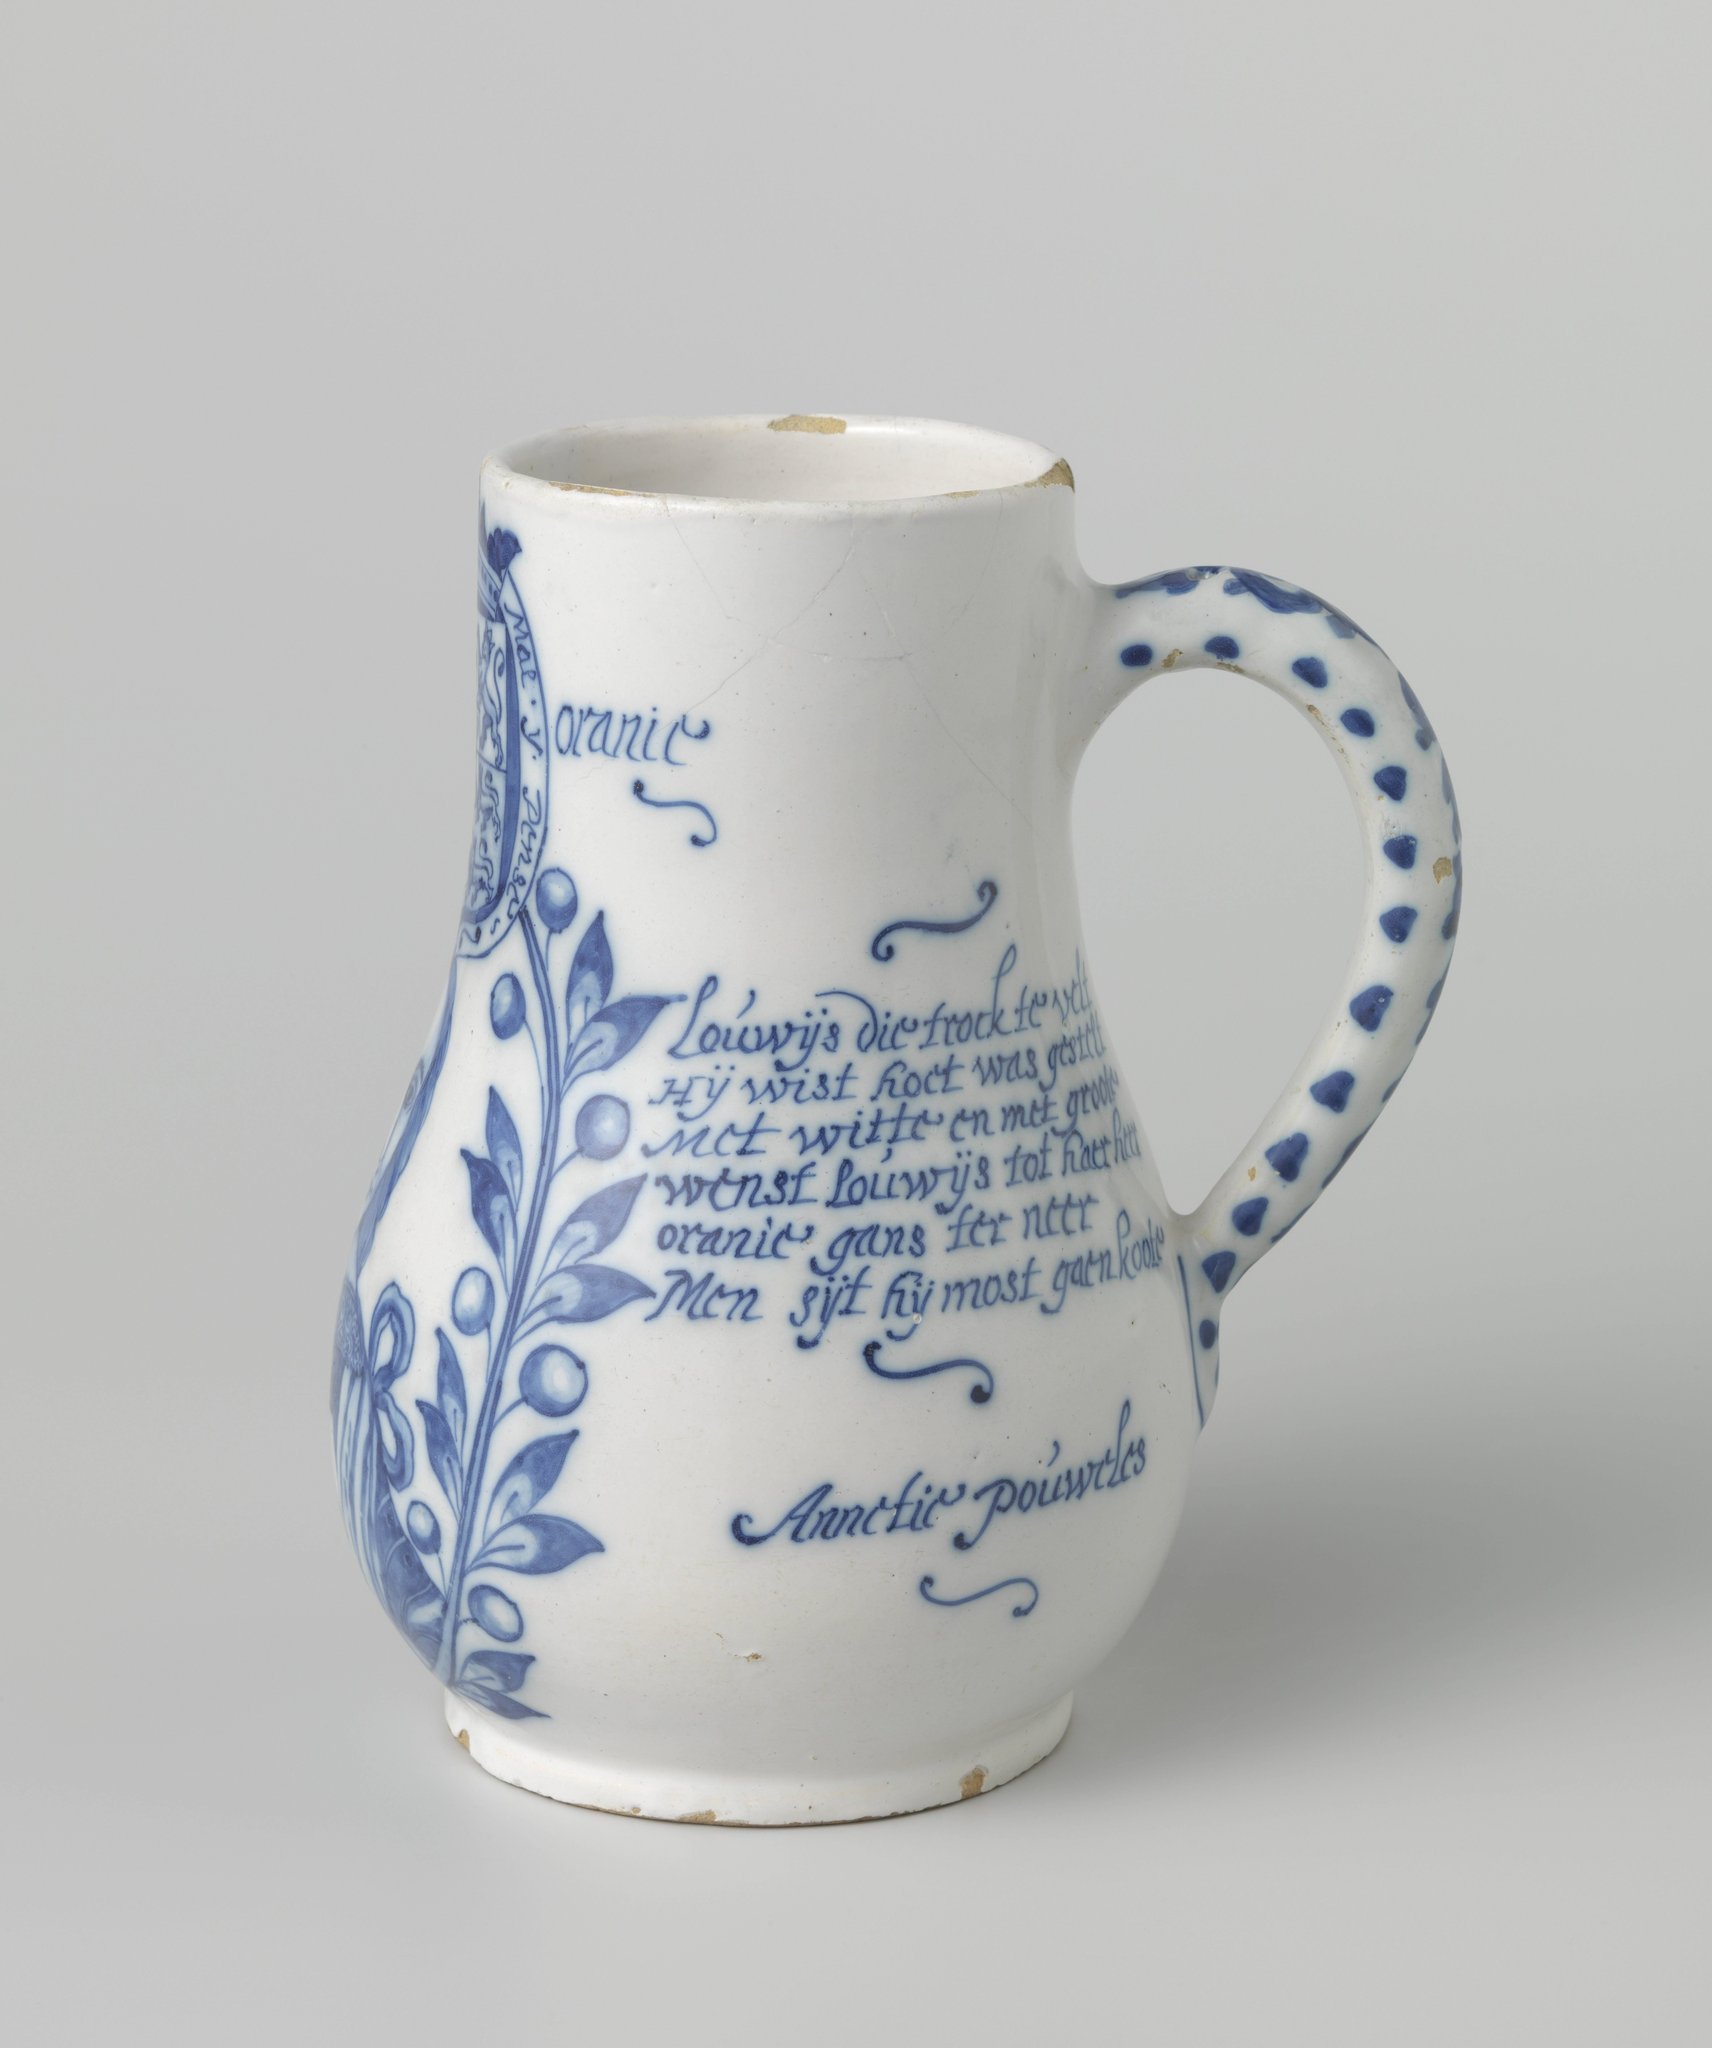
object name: ewer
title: Kan, beschilderd met het portret van Willem III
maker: Anonymous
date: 1674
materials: earthenware, glaze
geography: delft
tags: william iii (prince of orange and king of england, scotland, and ireland), historical persons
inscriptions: date: ‘1674’, inscription: ‘Leendert Pieterse van Velse Annetje Pouwels’, poem: ‘Louwijs die trock te velt/ Hij wist hoet was gestelt/ Met witte en met groote/ Wenst Louwijs tot haer heer / Oranie gans ter neer/ men sijt hij most gaen koote’, inscription: ‘honi . soijt . quij - mal . y . pense’, inscription: ‘vijva oranie’, poem: ‘Danck sij den opperheer/ Oranie herstelt weer/ na geen Louwijs begeere/ nogh wit of groots geslaght/ die haddent niet ghedaght/ lof sij den heer der heere’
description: Jug with portrait and arms of William III. Delftware, 1674. Two poems about the war and the names of those who commissioned the piece are inscribed on the jug.